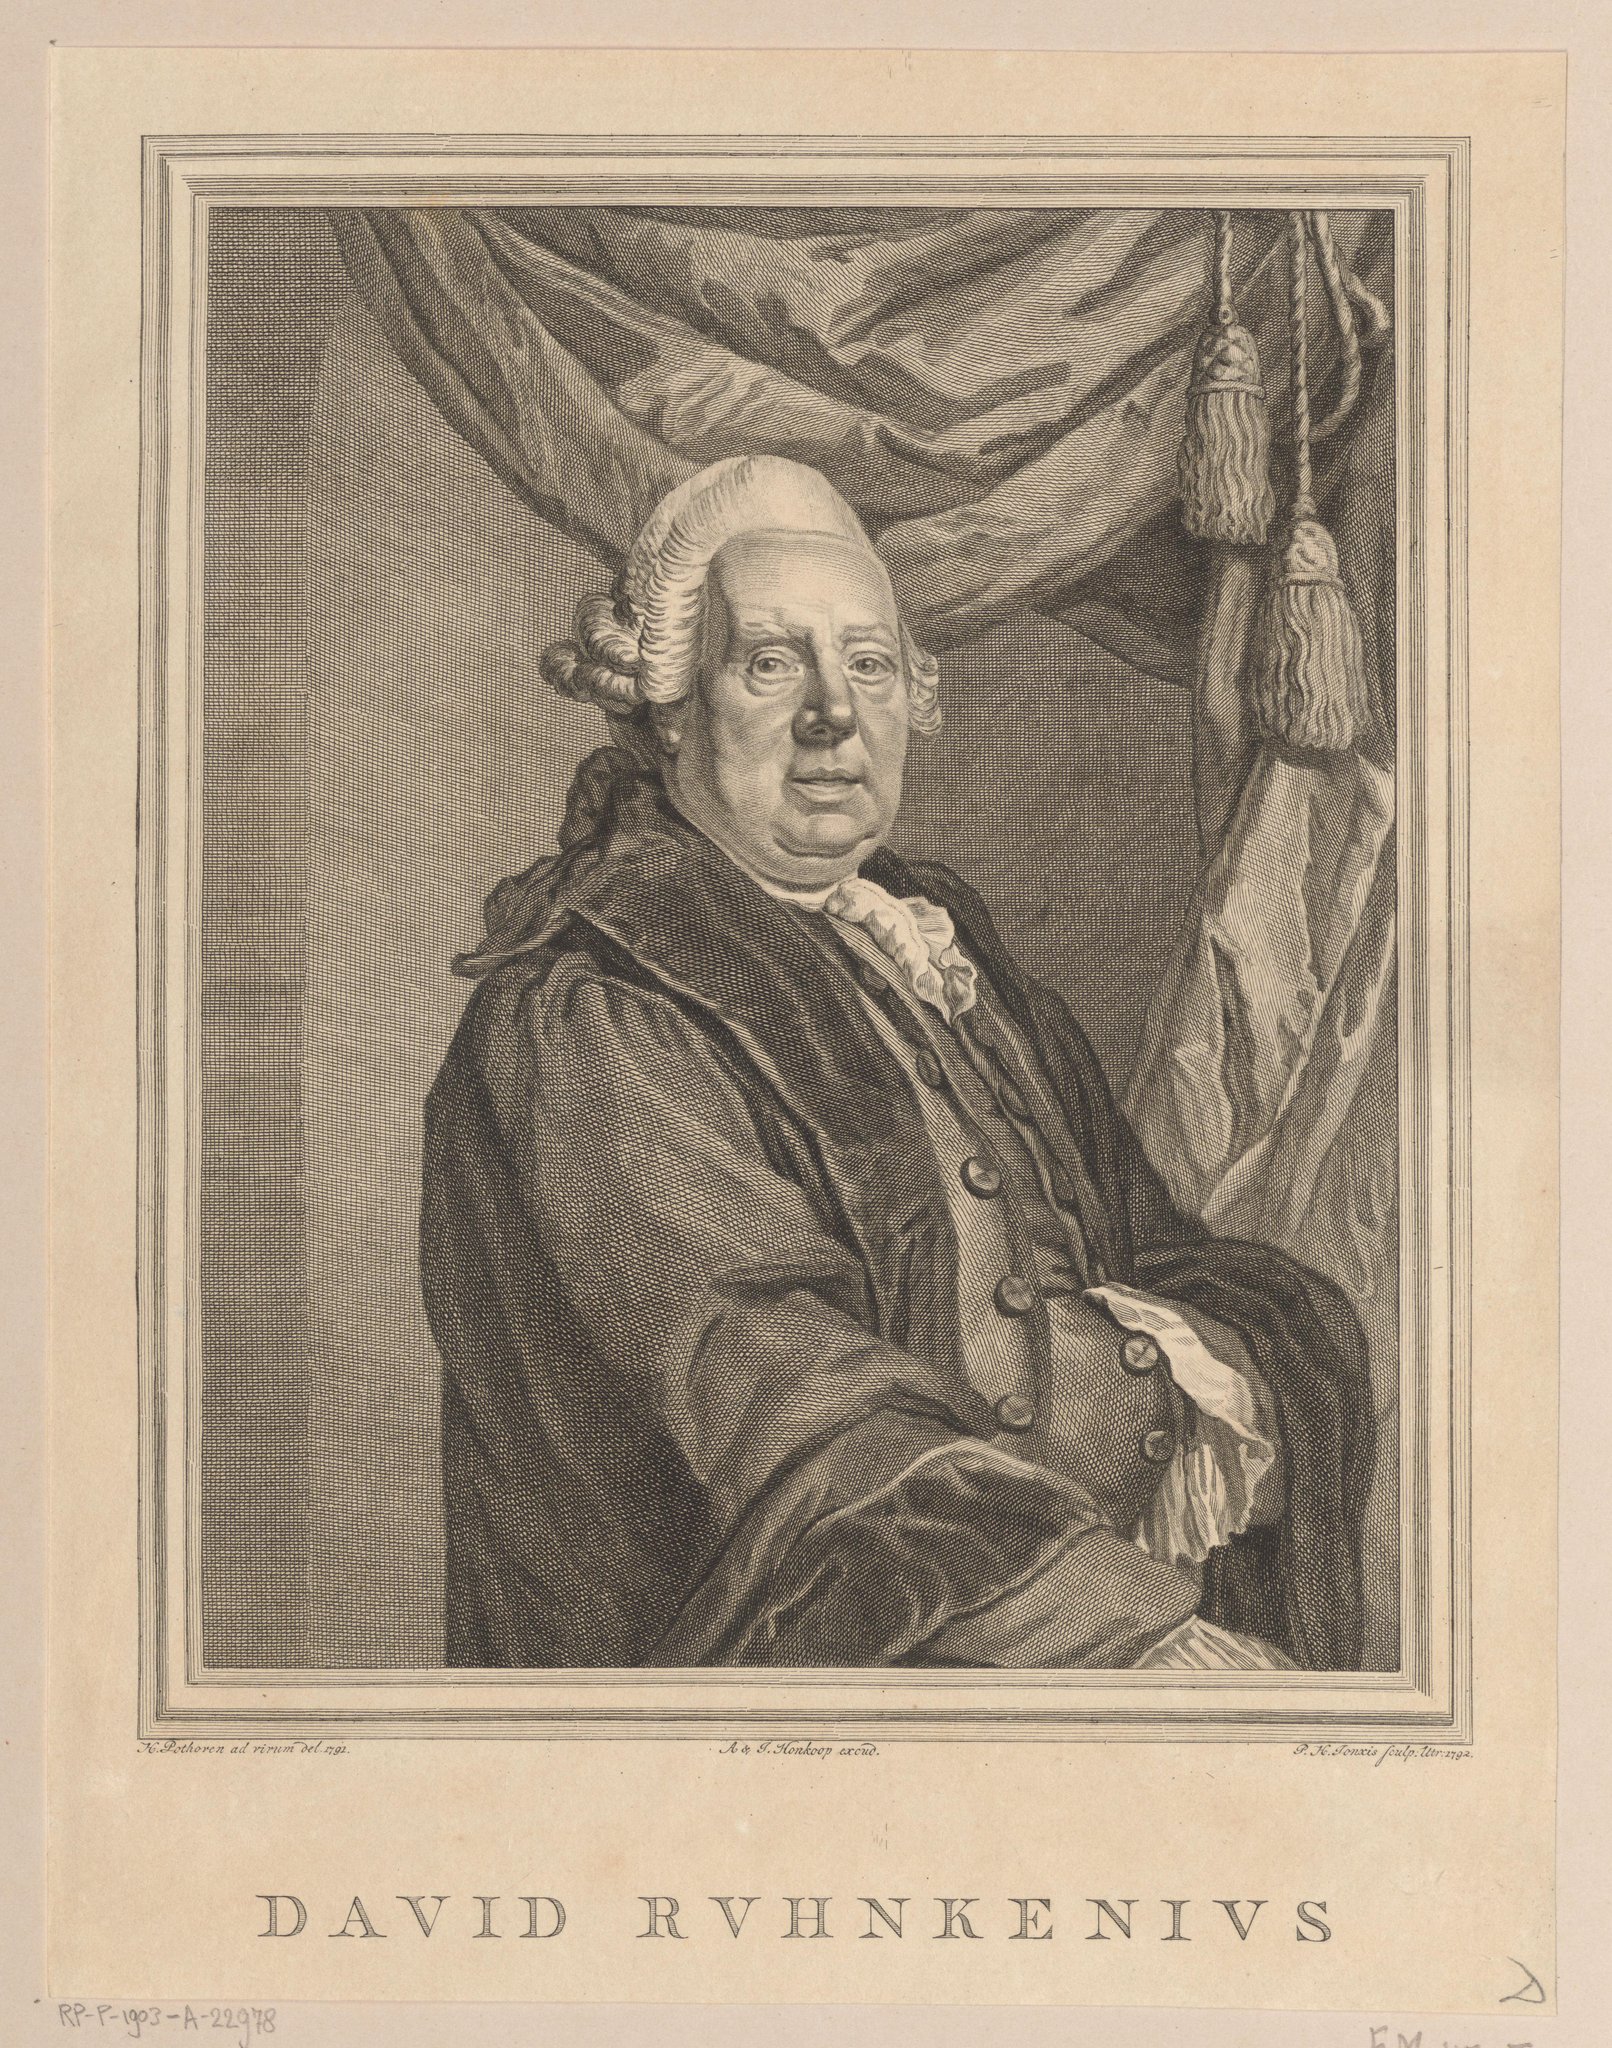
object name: print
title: Portret van David Ruhnken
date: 1792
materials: paper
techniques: engraving, etching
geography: leiden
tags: leiden, historical persons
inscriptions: collector's mark: Lugt 2228